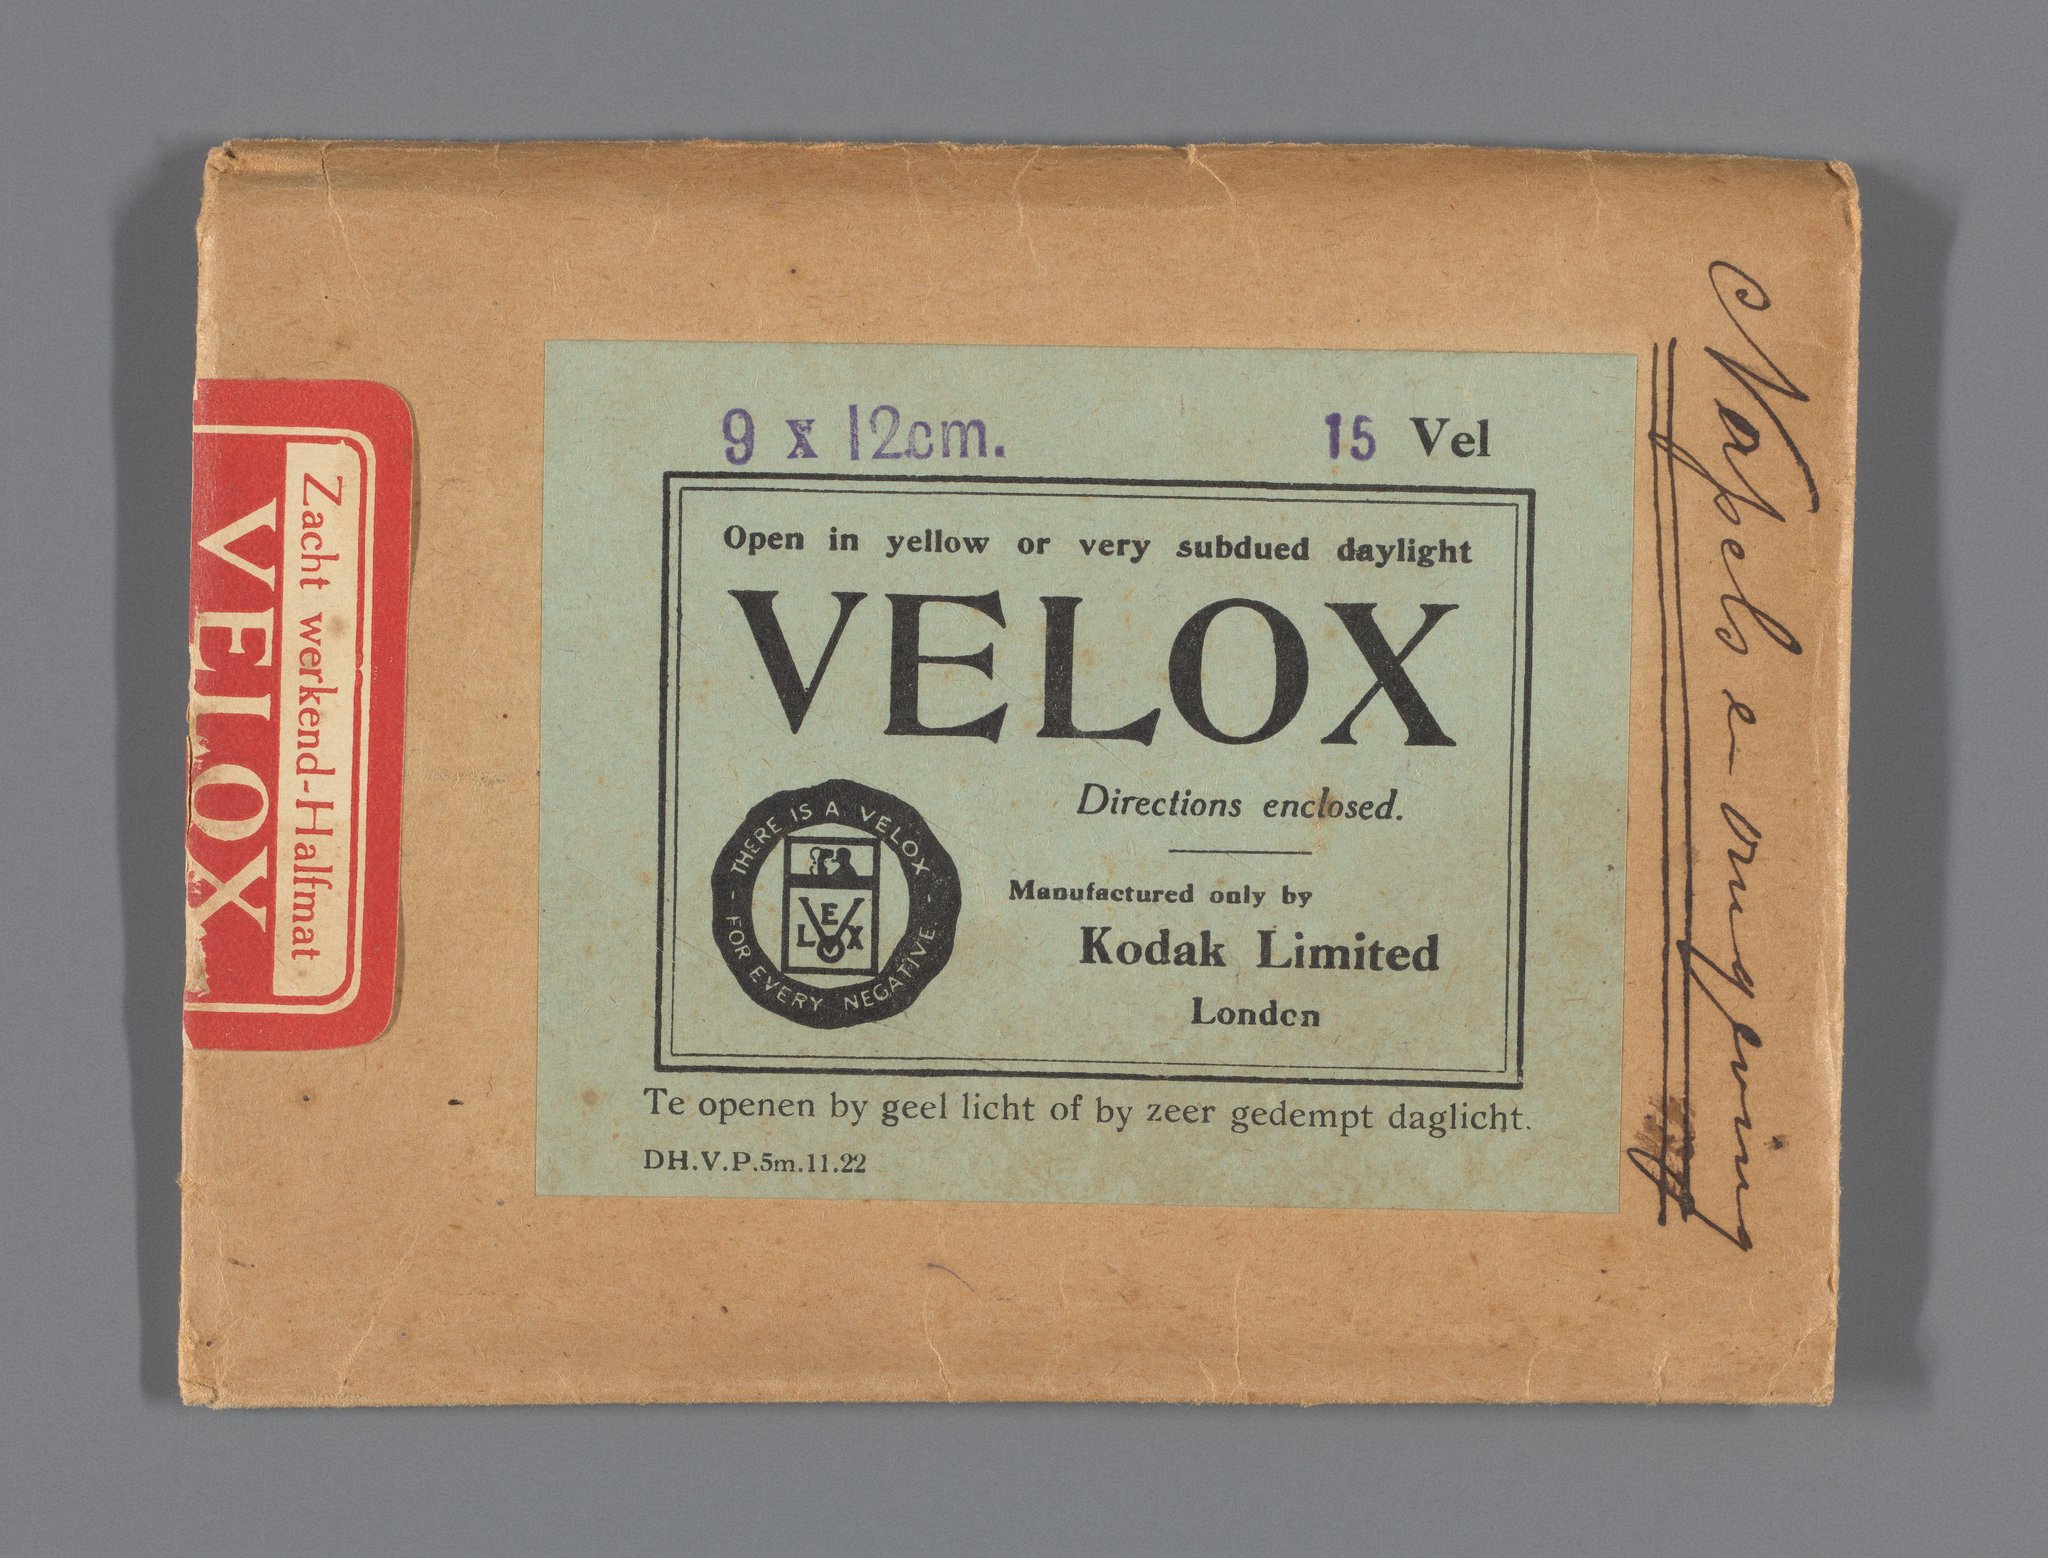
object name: envelope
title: Envelop voor fotopapier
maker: Anonymous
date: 1907-1935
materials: paper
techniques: printing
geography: europe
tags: italy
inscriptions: inscription: ‘Florence’